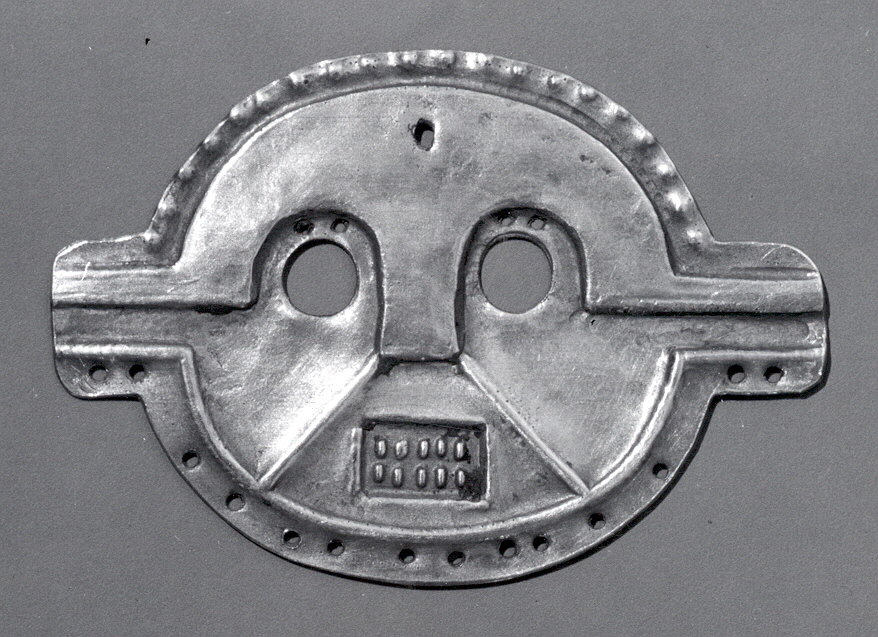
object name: ornament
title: Ornament, Face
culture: calima or yotoco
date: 1-700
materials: gold, paint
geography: colombia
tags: faces